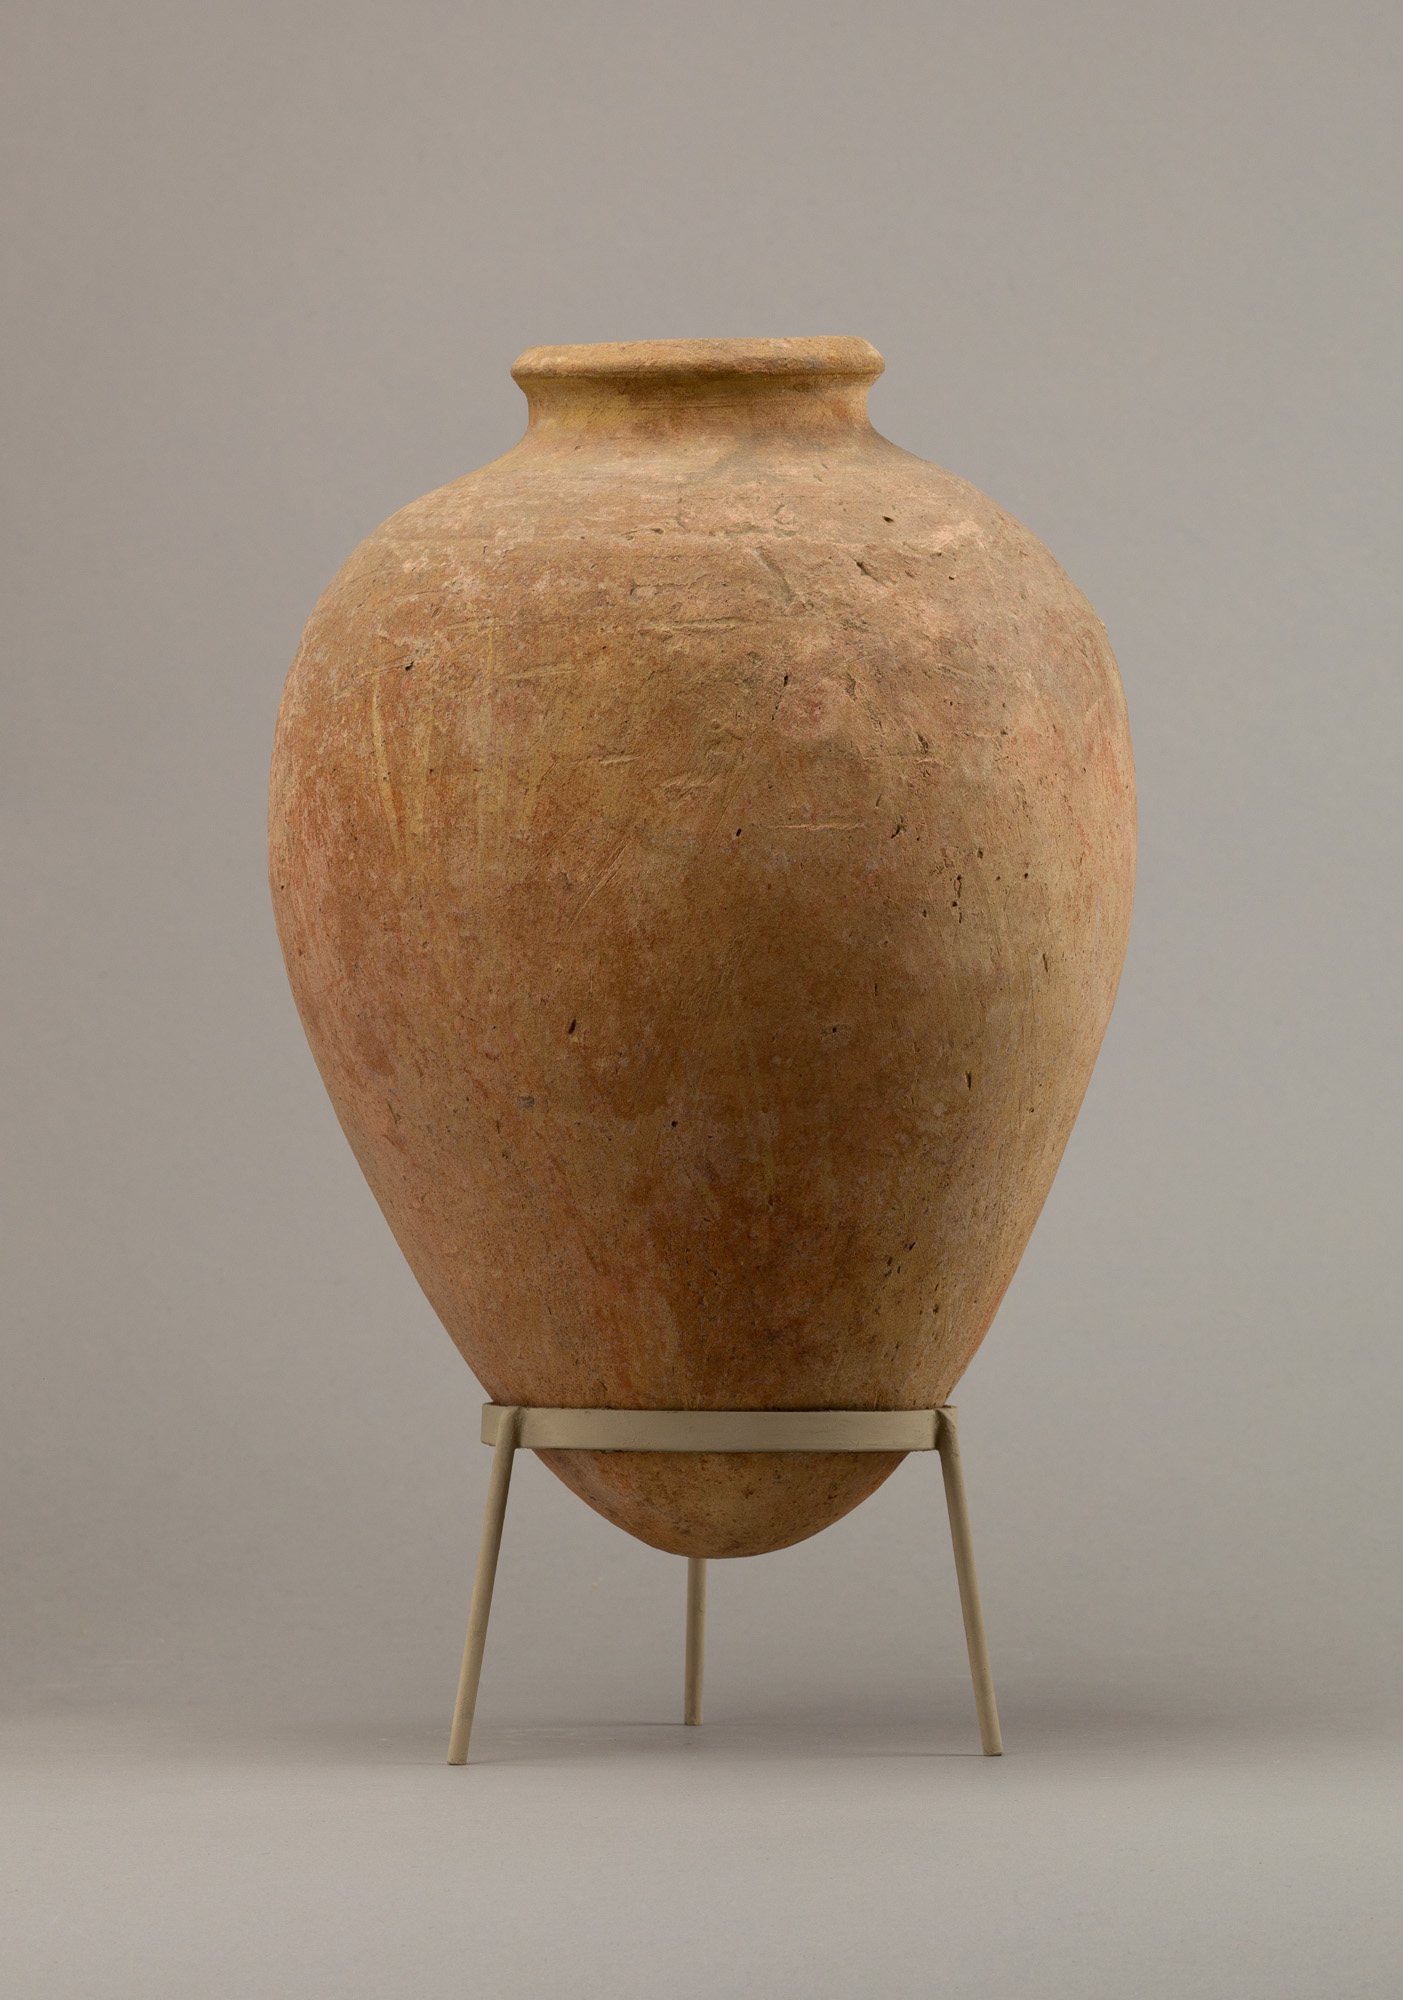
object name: jar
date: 2649-2100 BCE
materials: pottery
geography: egypt